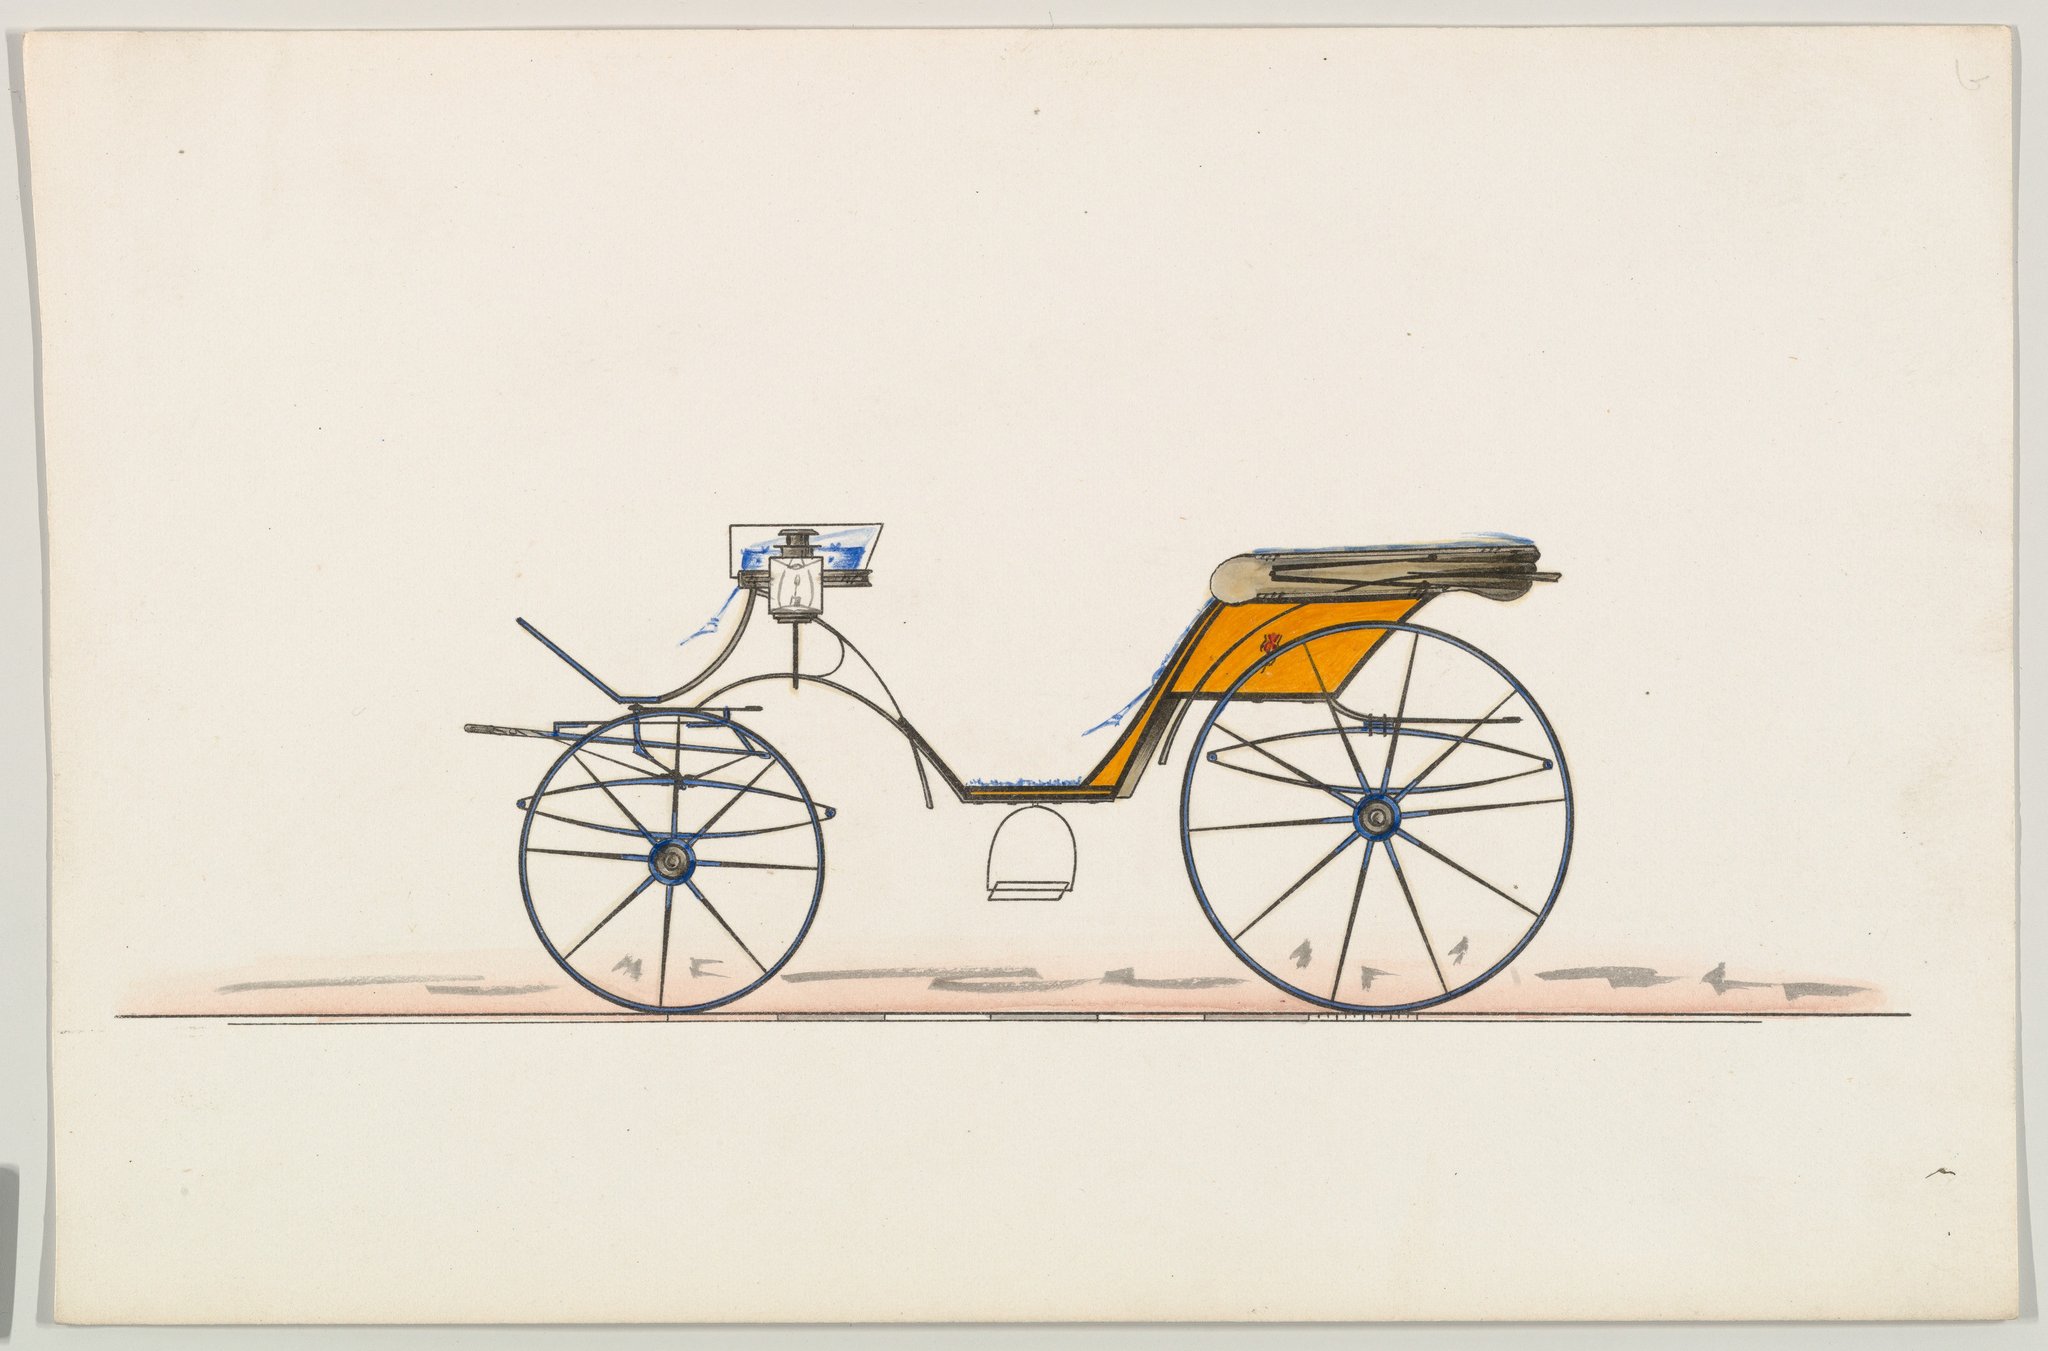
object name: drawing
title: Victoria (unnumbered)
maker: brewster & co.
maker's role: manufacturer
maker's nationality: american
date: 1870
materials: gouache, ink, watercolor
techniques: pen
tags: carriages